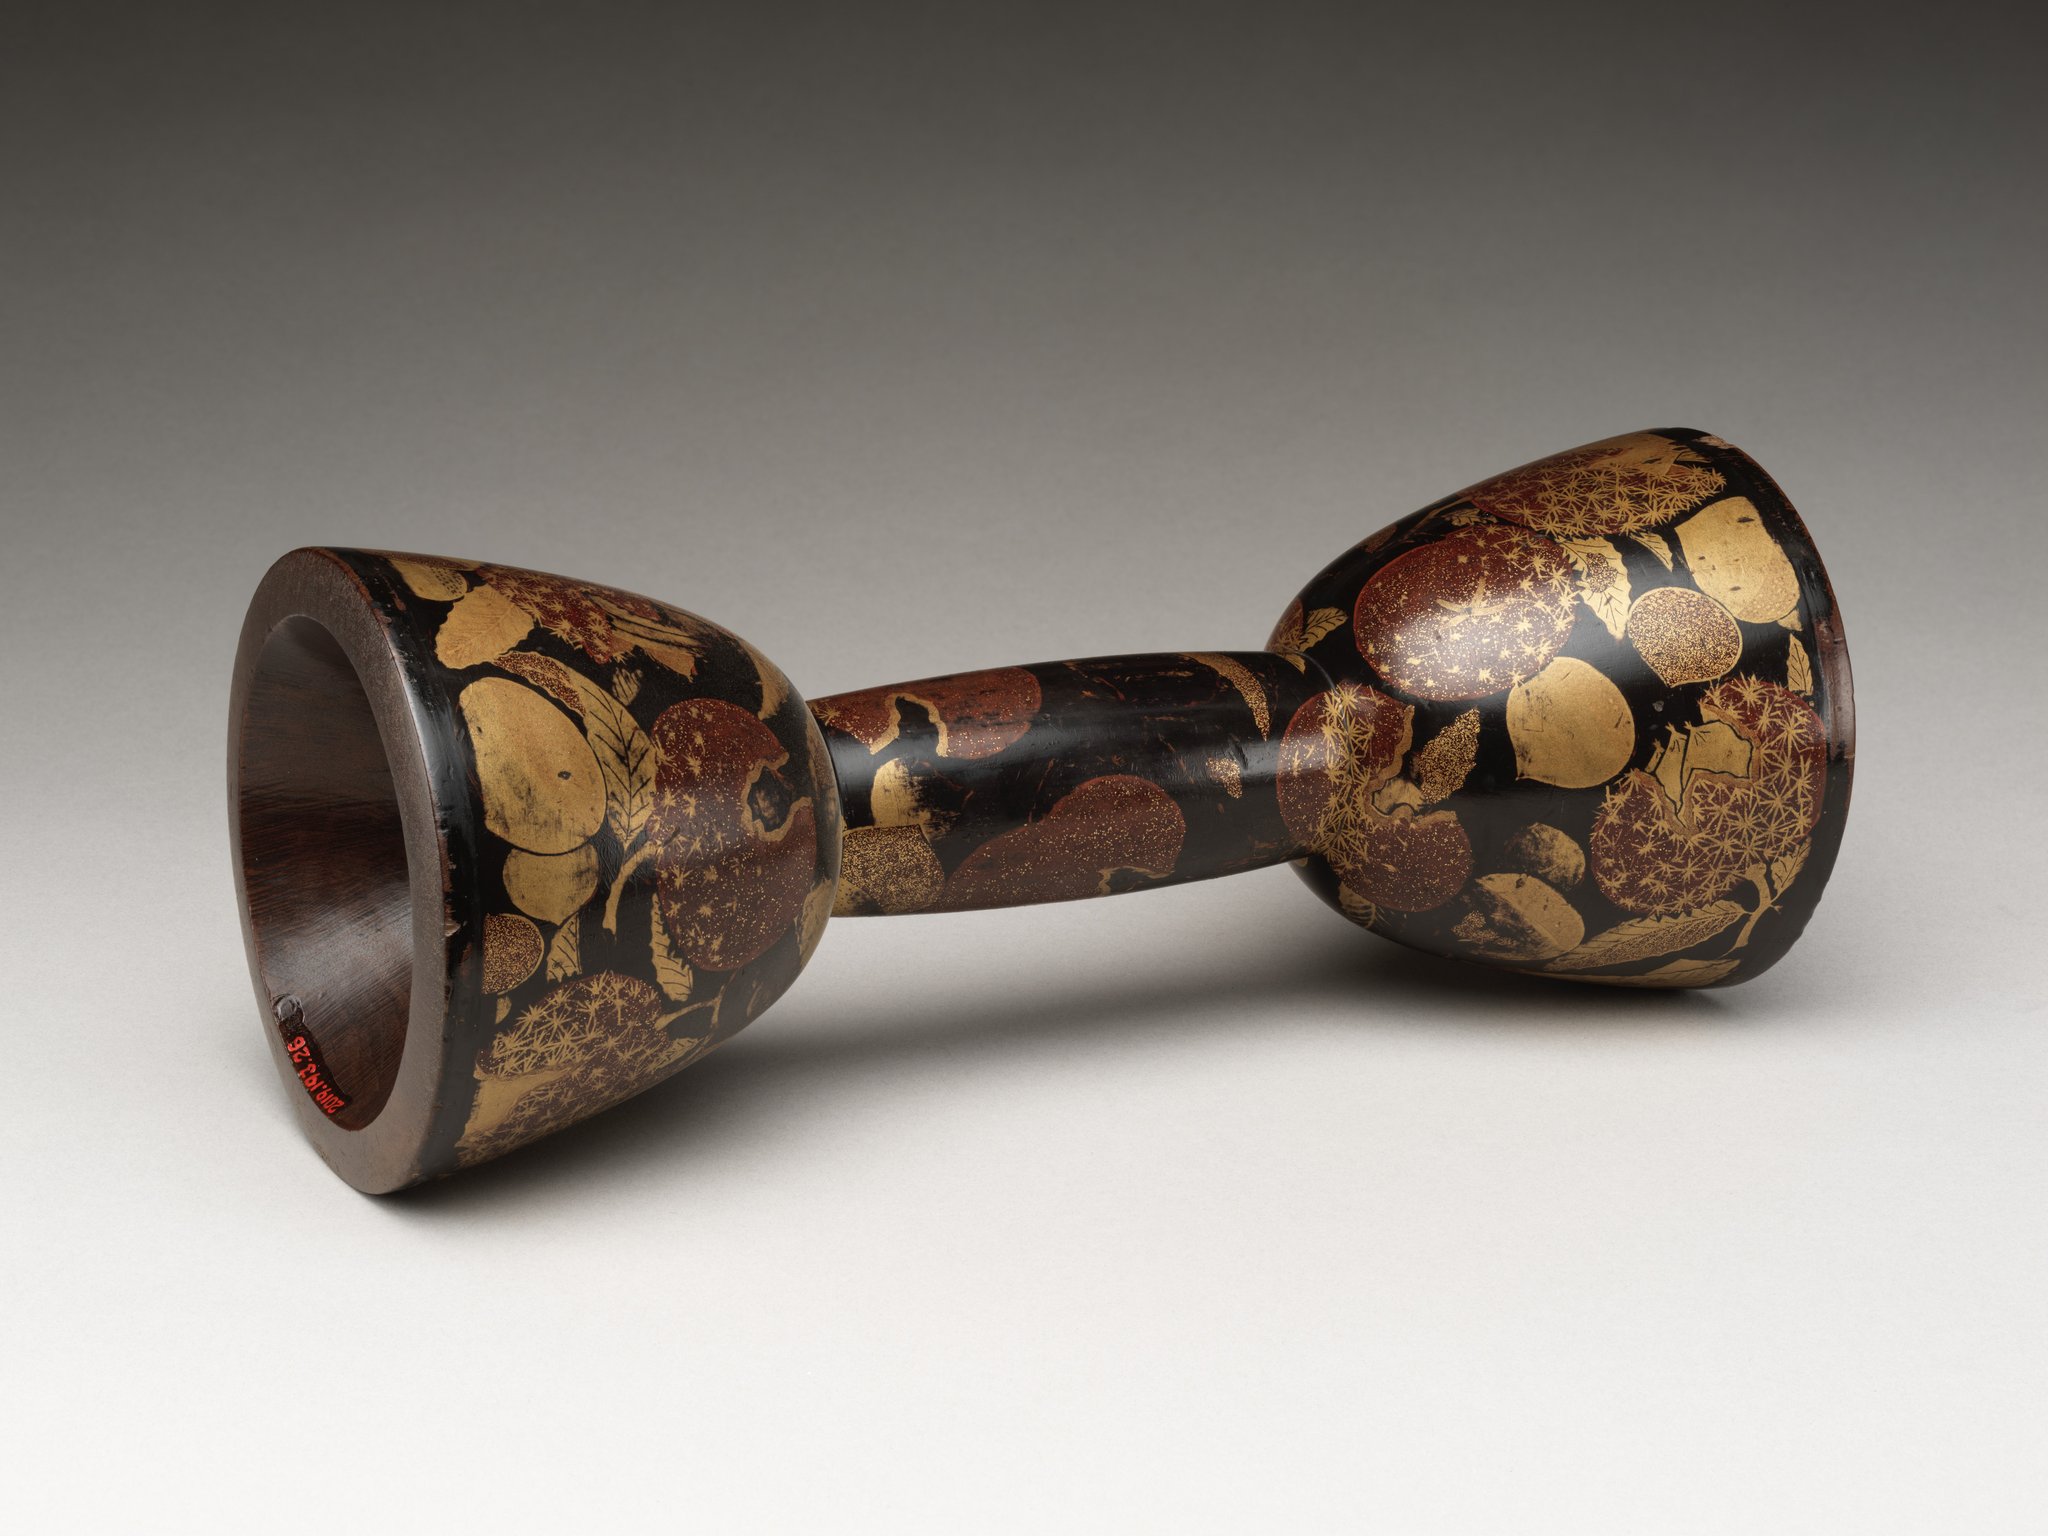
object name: drum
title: Small Shoulder Drum (Kotsuzumi) with Chestnuts for Noh Performance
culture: japanese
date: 1601-1633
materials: gold, wood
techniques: hiramakie, lacquer